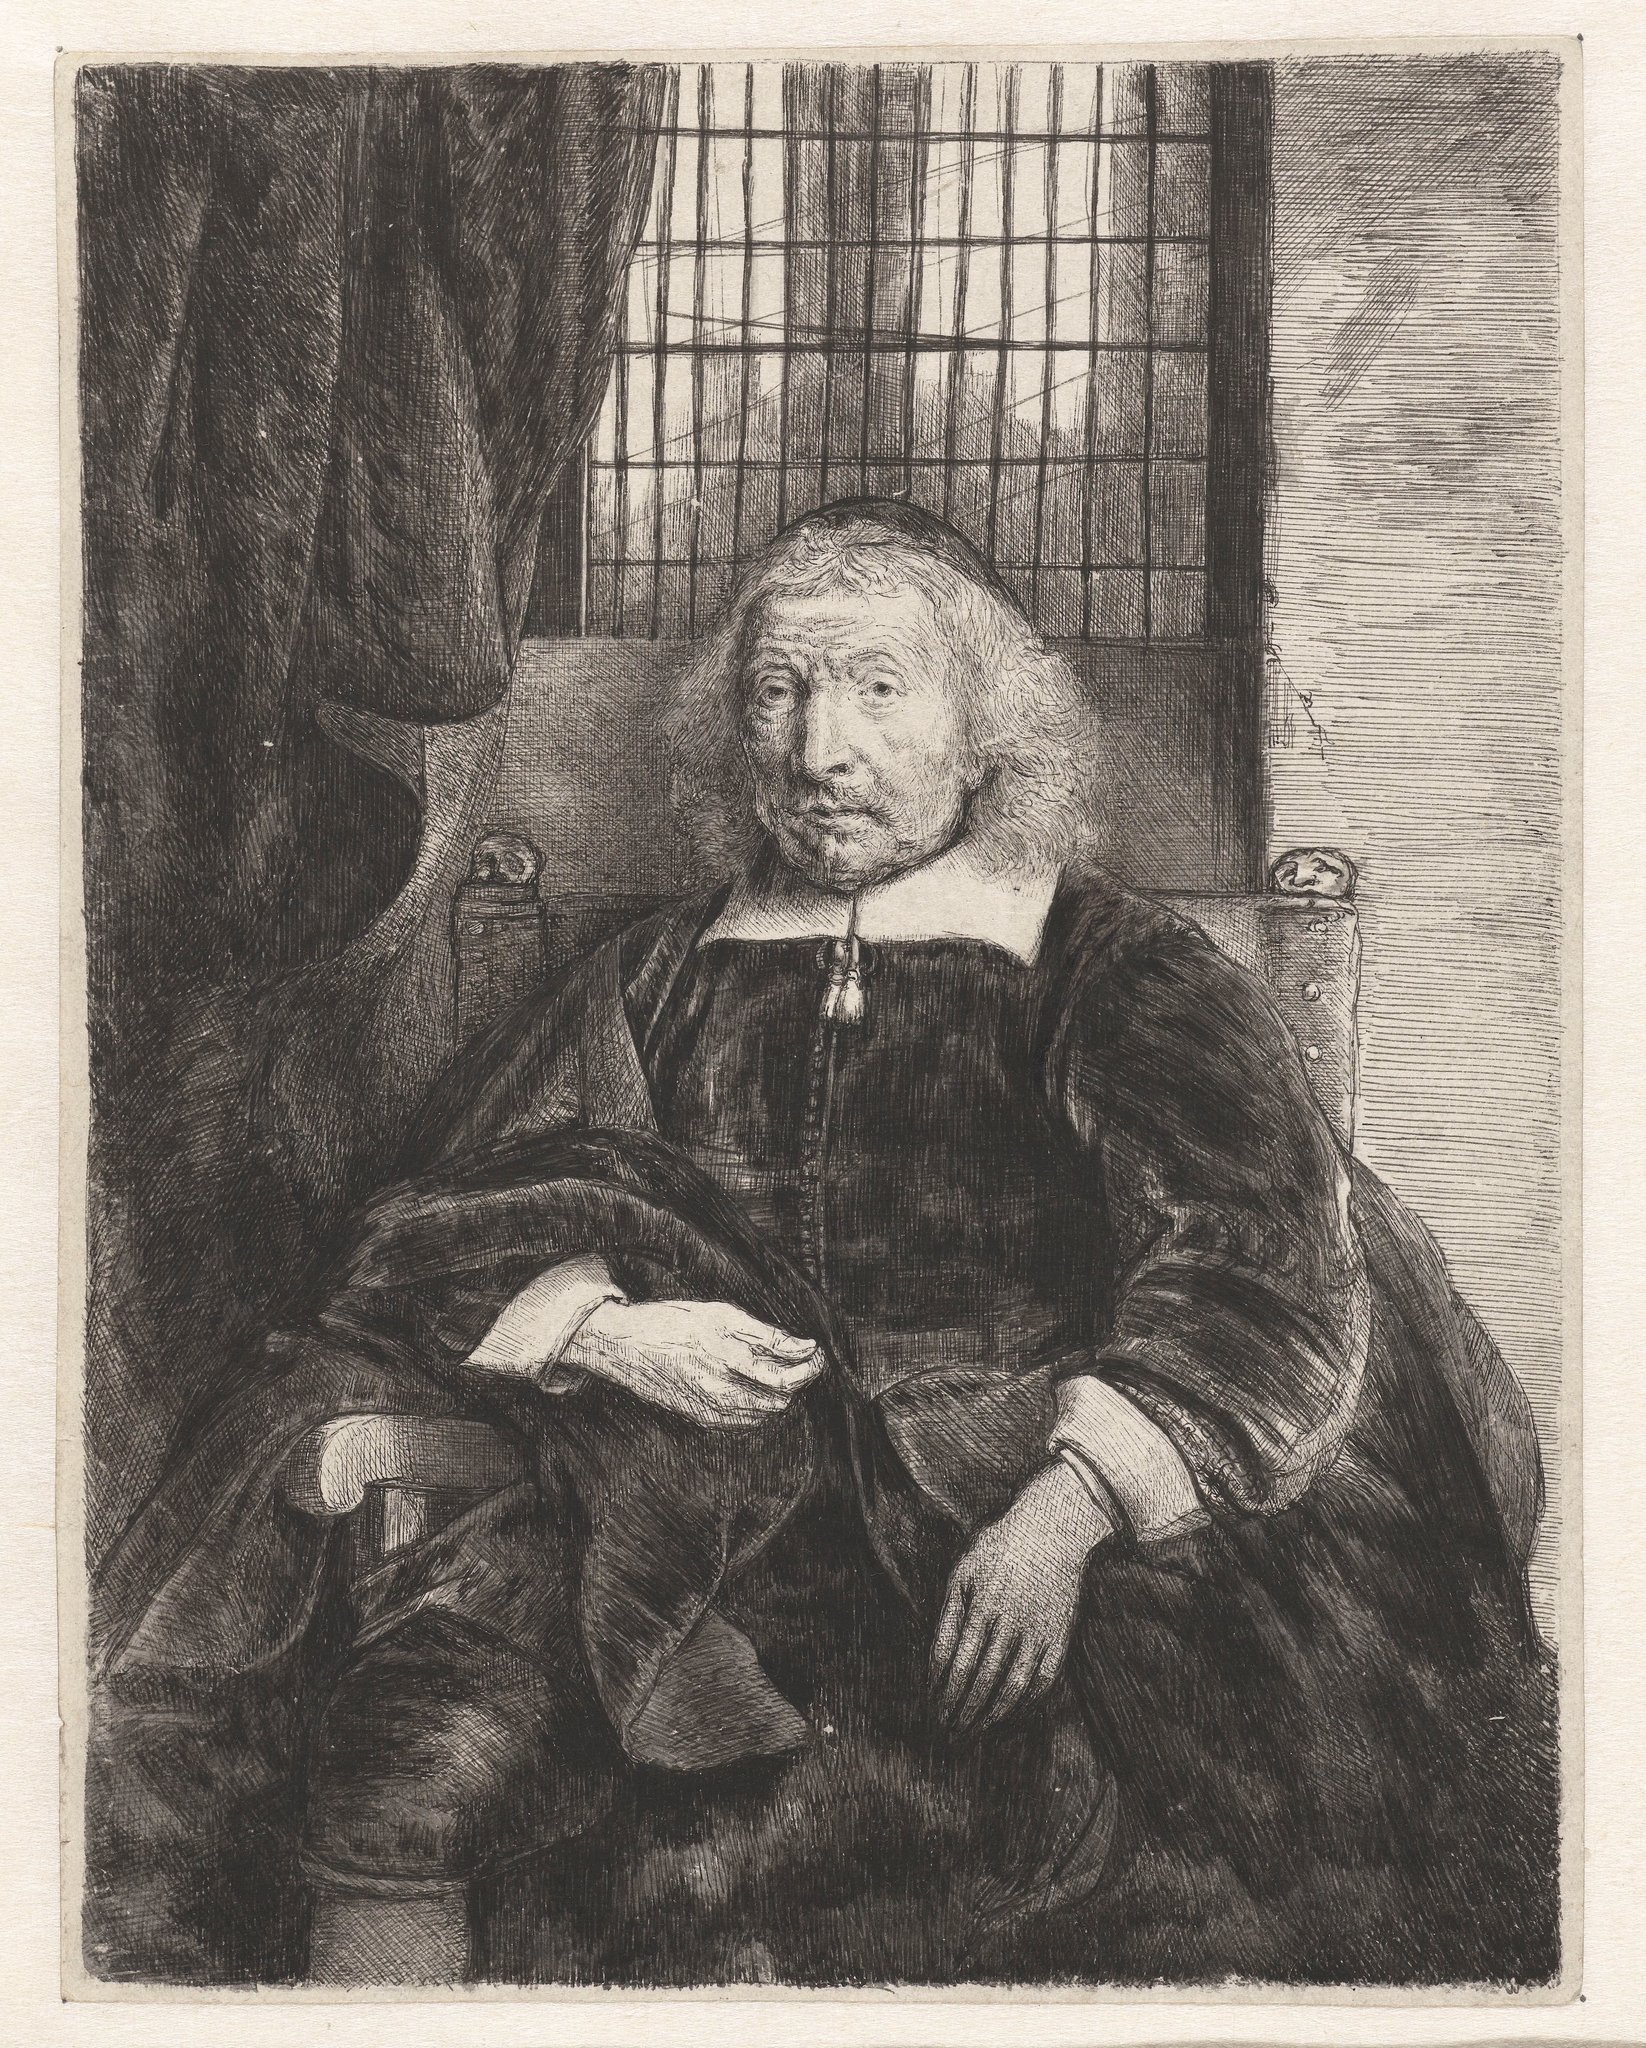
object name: print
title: Thomas Haargingh ('Old Haaringh')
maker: Anonymous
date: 1655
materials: paper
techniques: etching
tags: historical persons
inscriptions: collector's mark: Lugt 2760, collector's mark: Lugt 2228